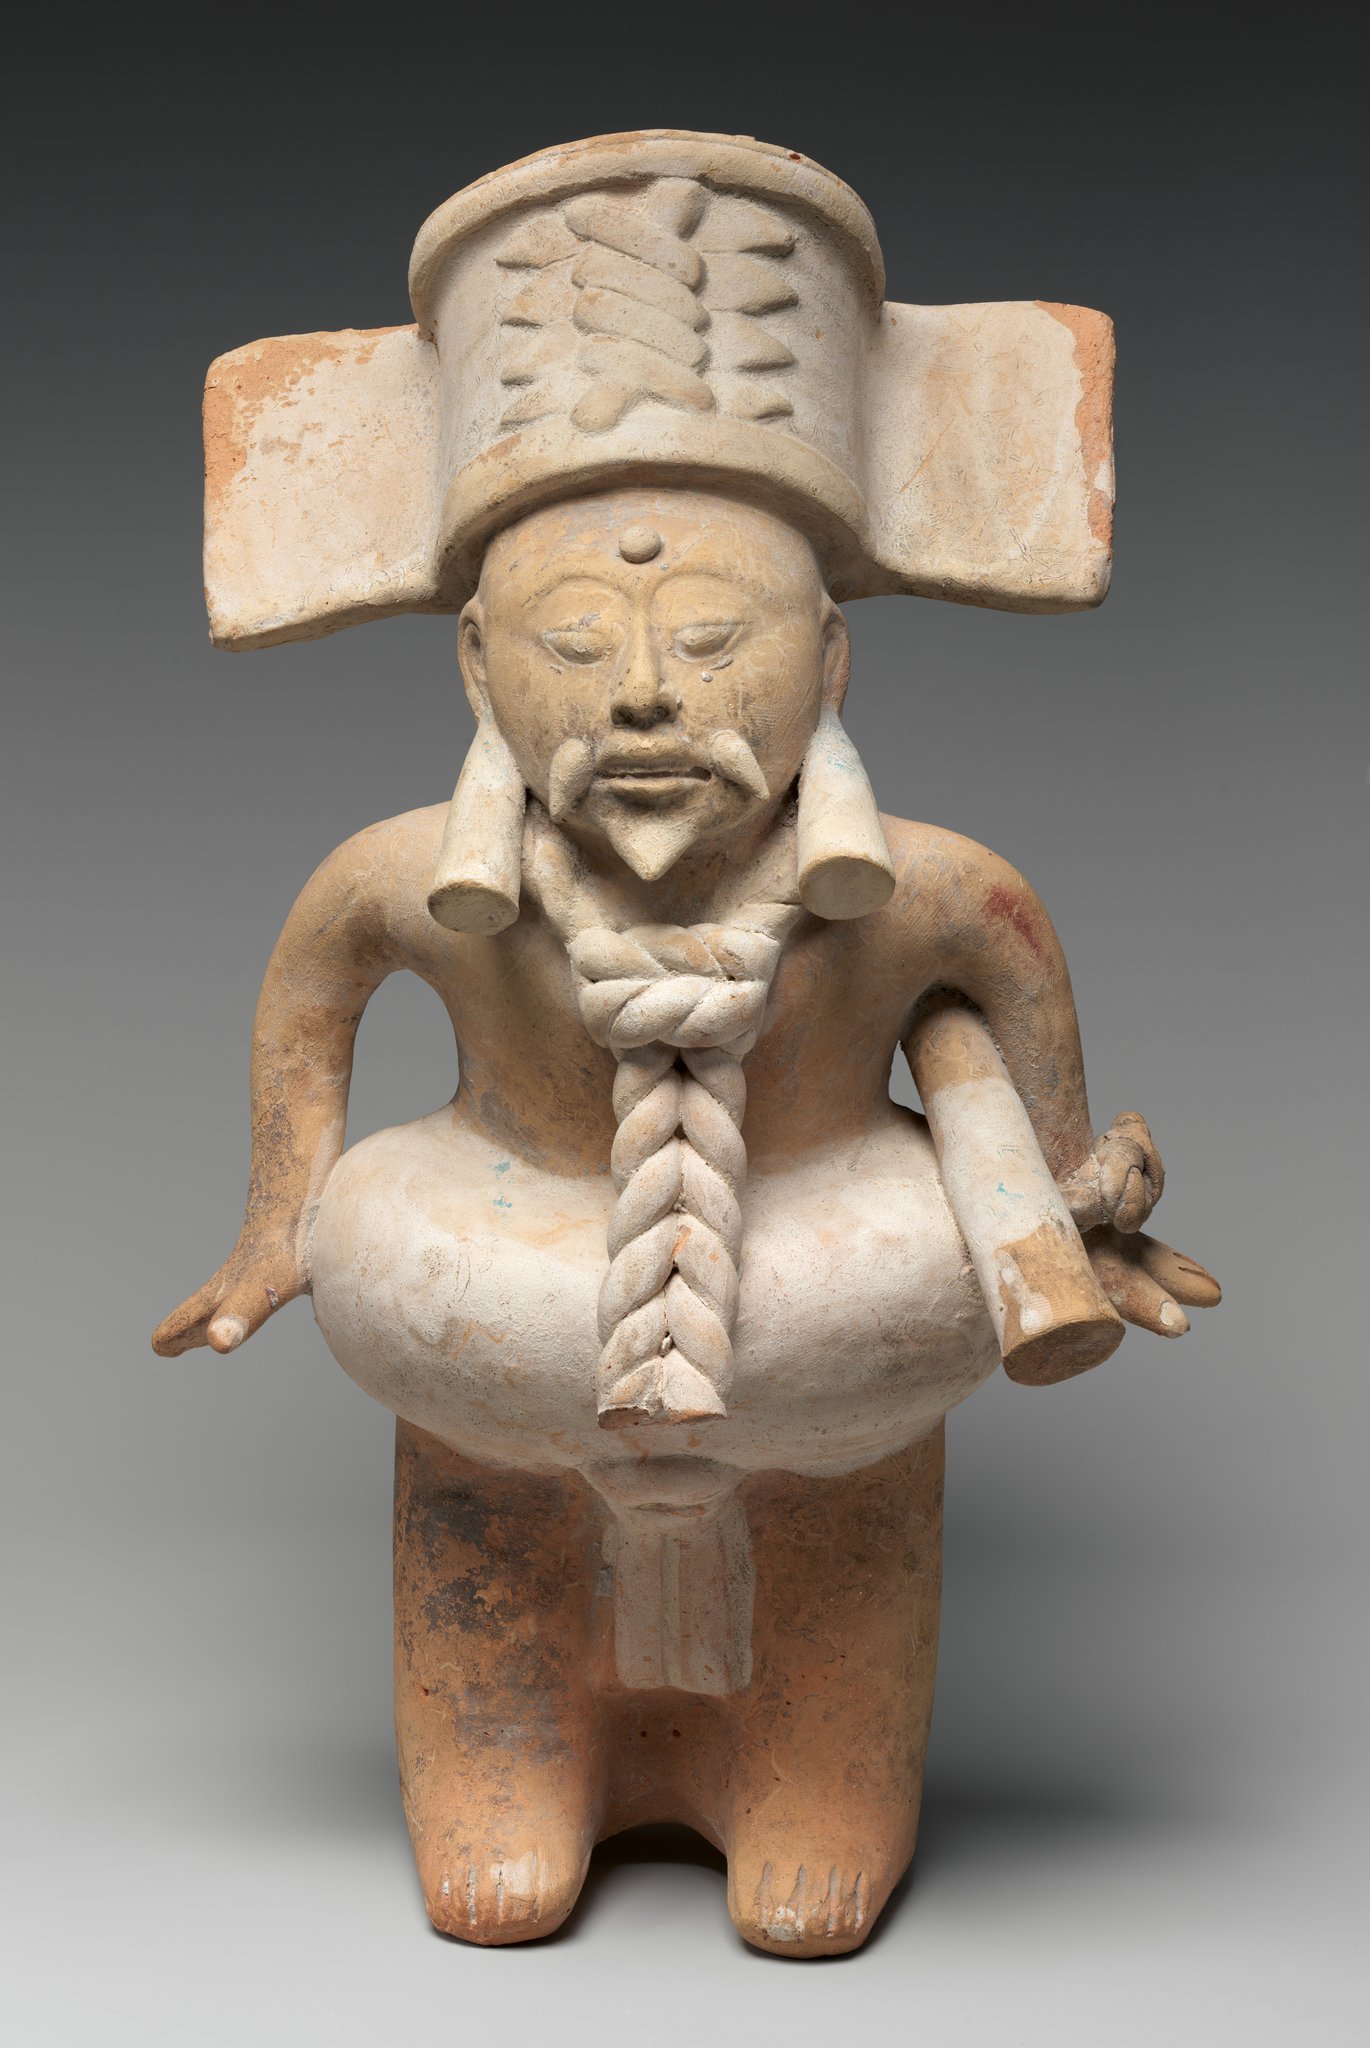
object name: male figure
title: Ball Player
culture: nopiloa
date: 601-1000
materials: ceramic, paint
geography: mexico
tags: men